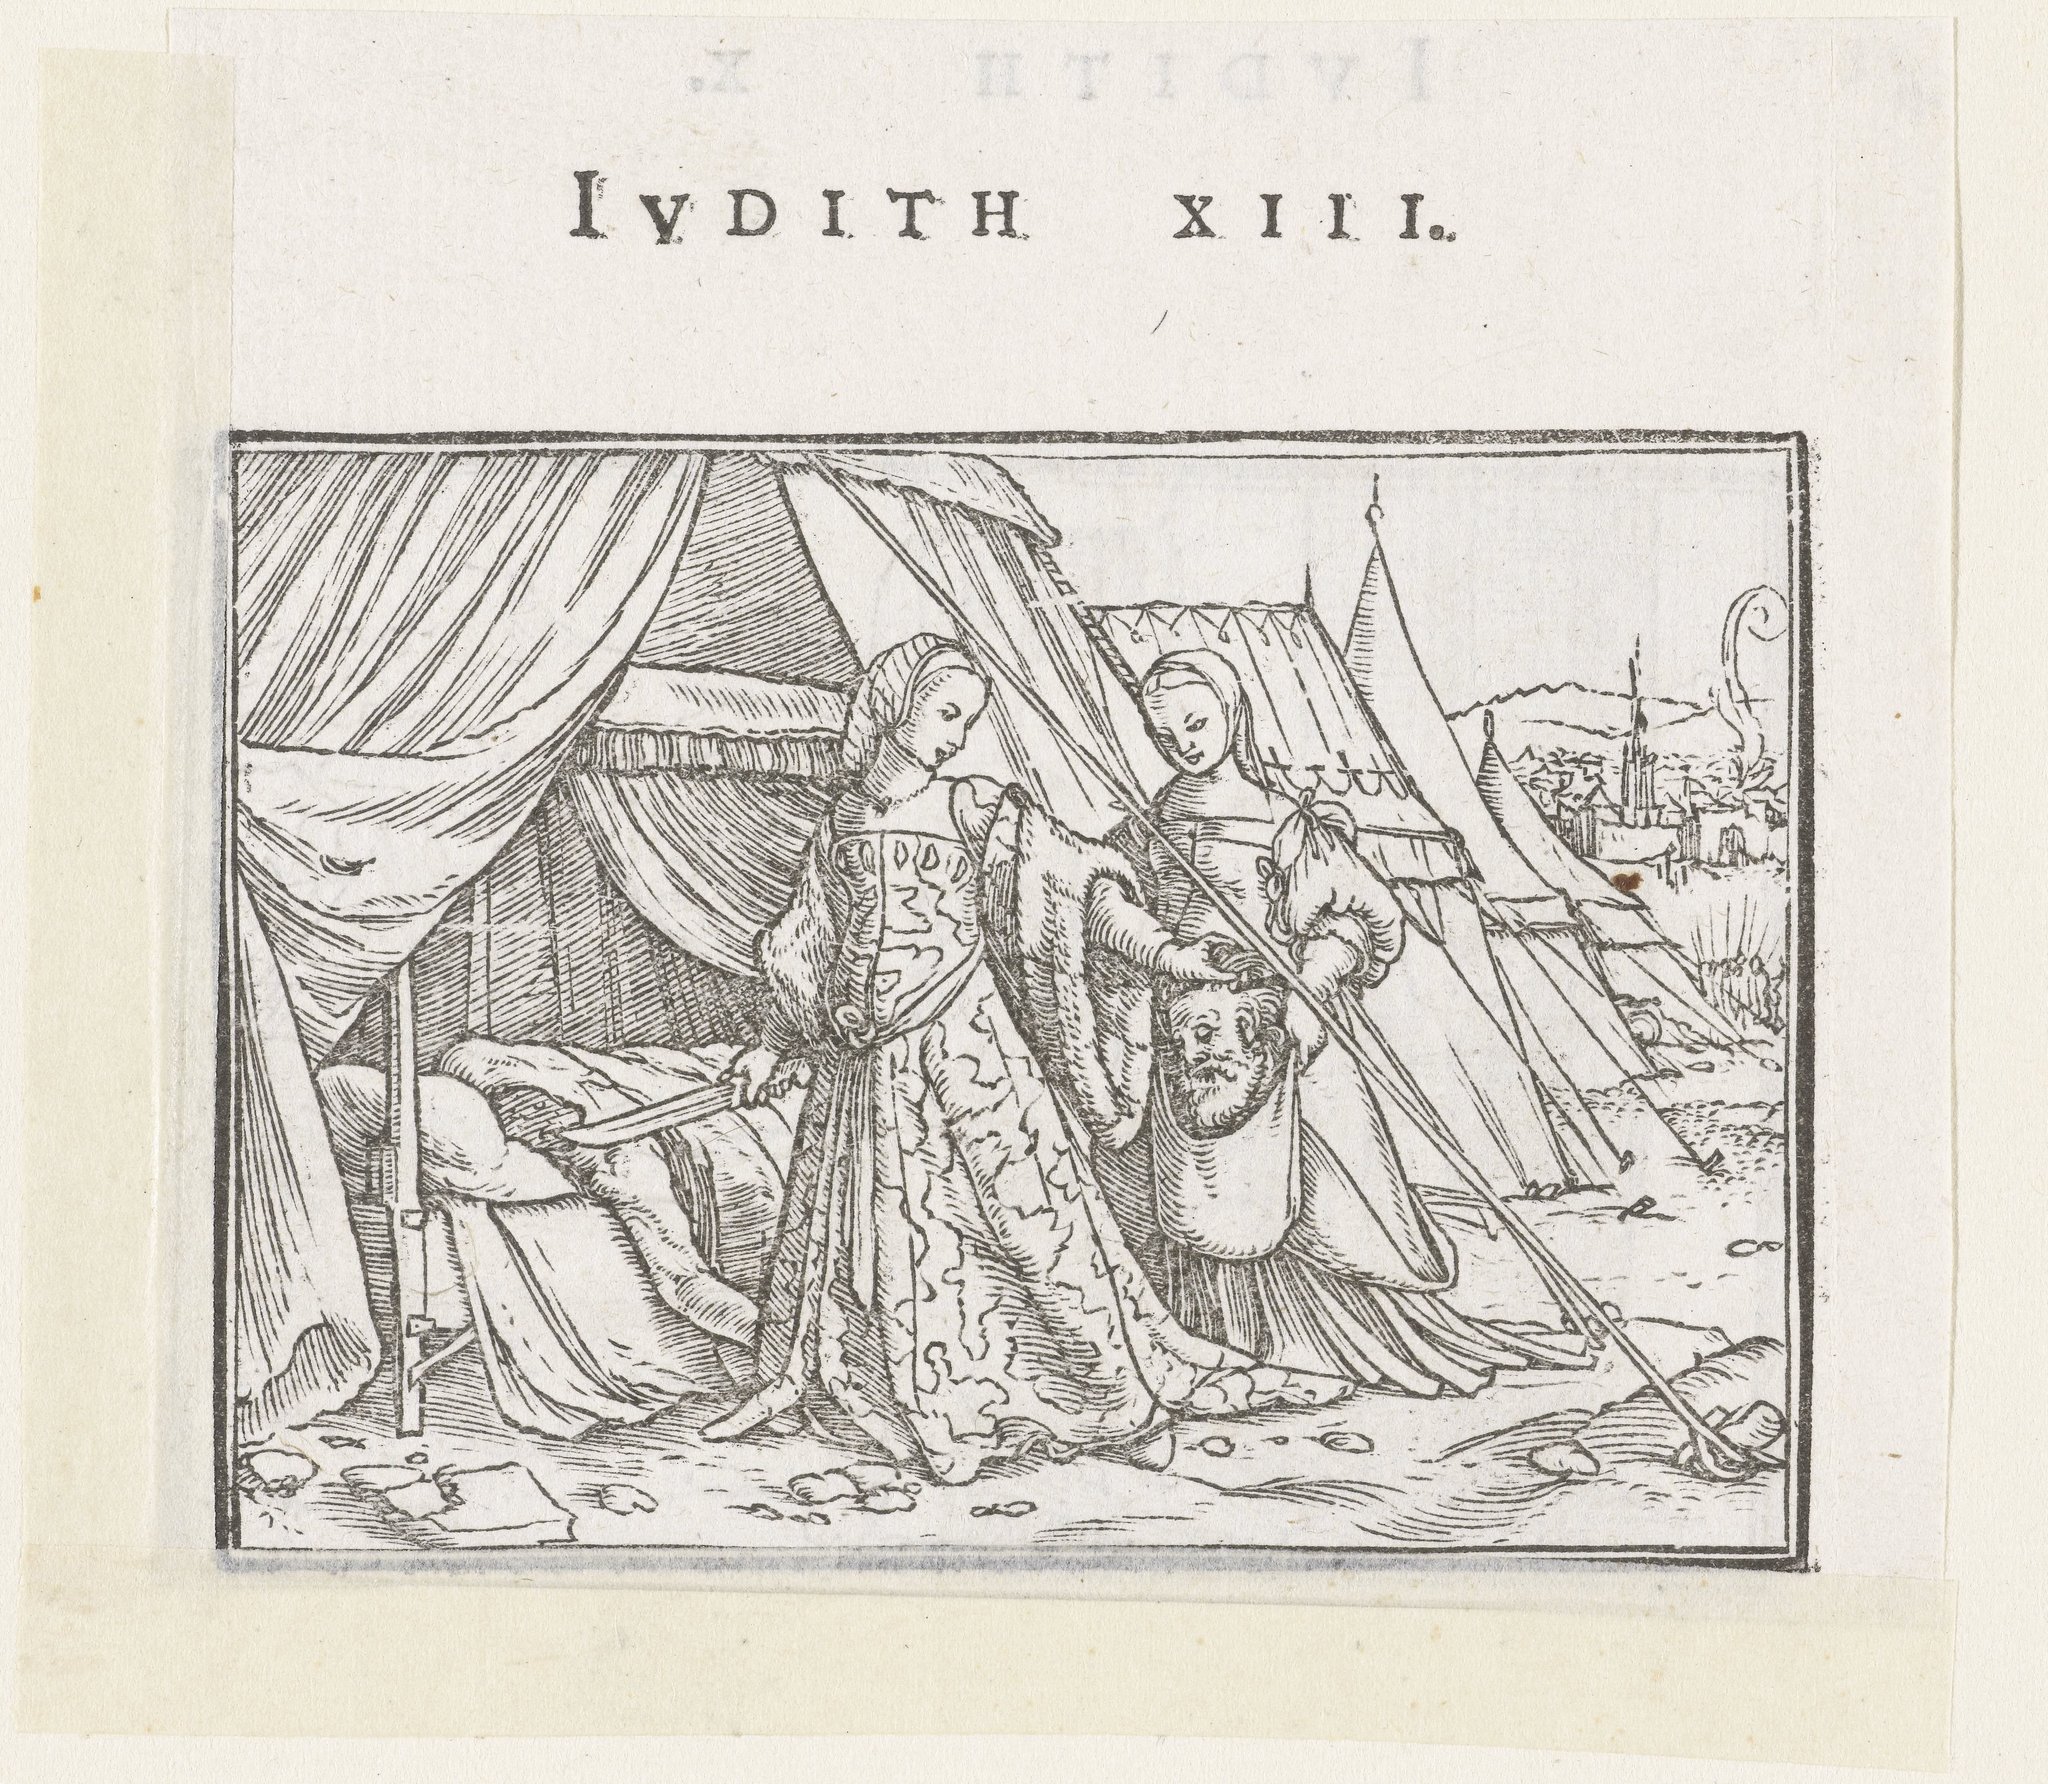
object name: print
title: Judit geeft hoofd van Holofernes aan haar slavin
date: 1538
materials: paper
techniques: woodcut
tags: judith and her maidservant put holofernes' head in a sack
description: Judit staat naast het bed waarop de dronken Holofernes ligt in zijn tent. Zij heeft zijn hoofd afgehakt en stopt het in de reistas van haar dienstmaagd. In de marge boven de afbeelding staat de tekst Judith XIII.